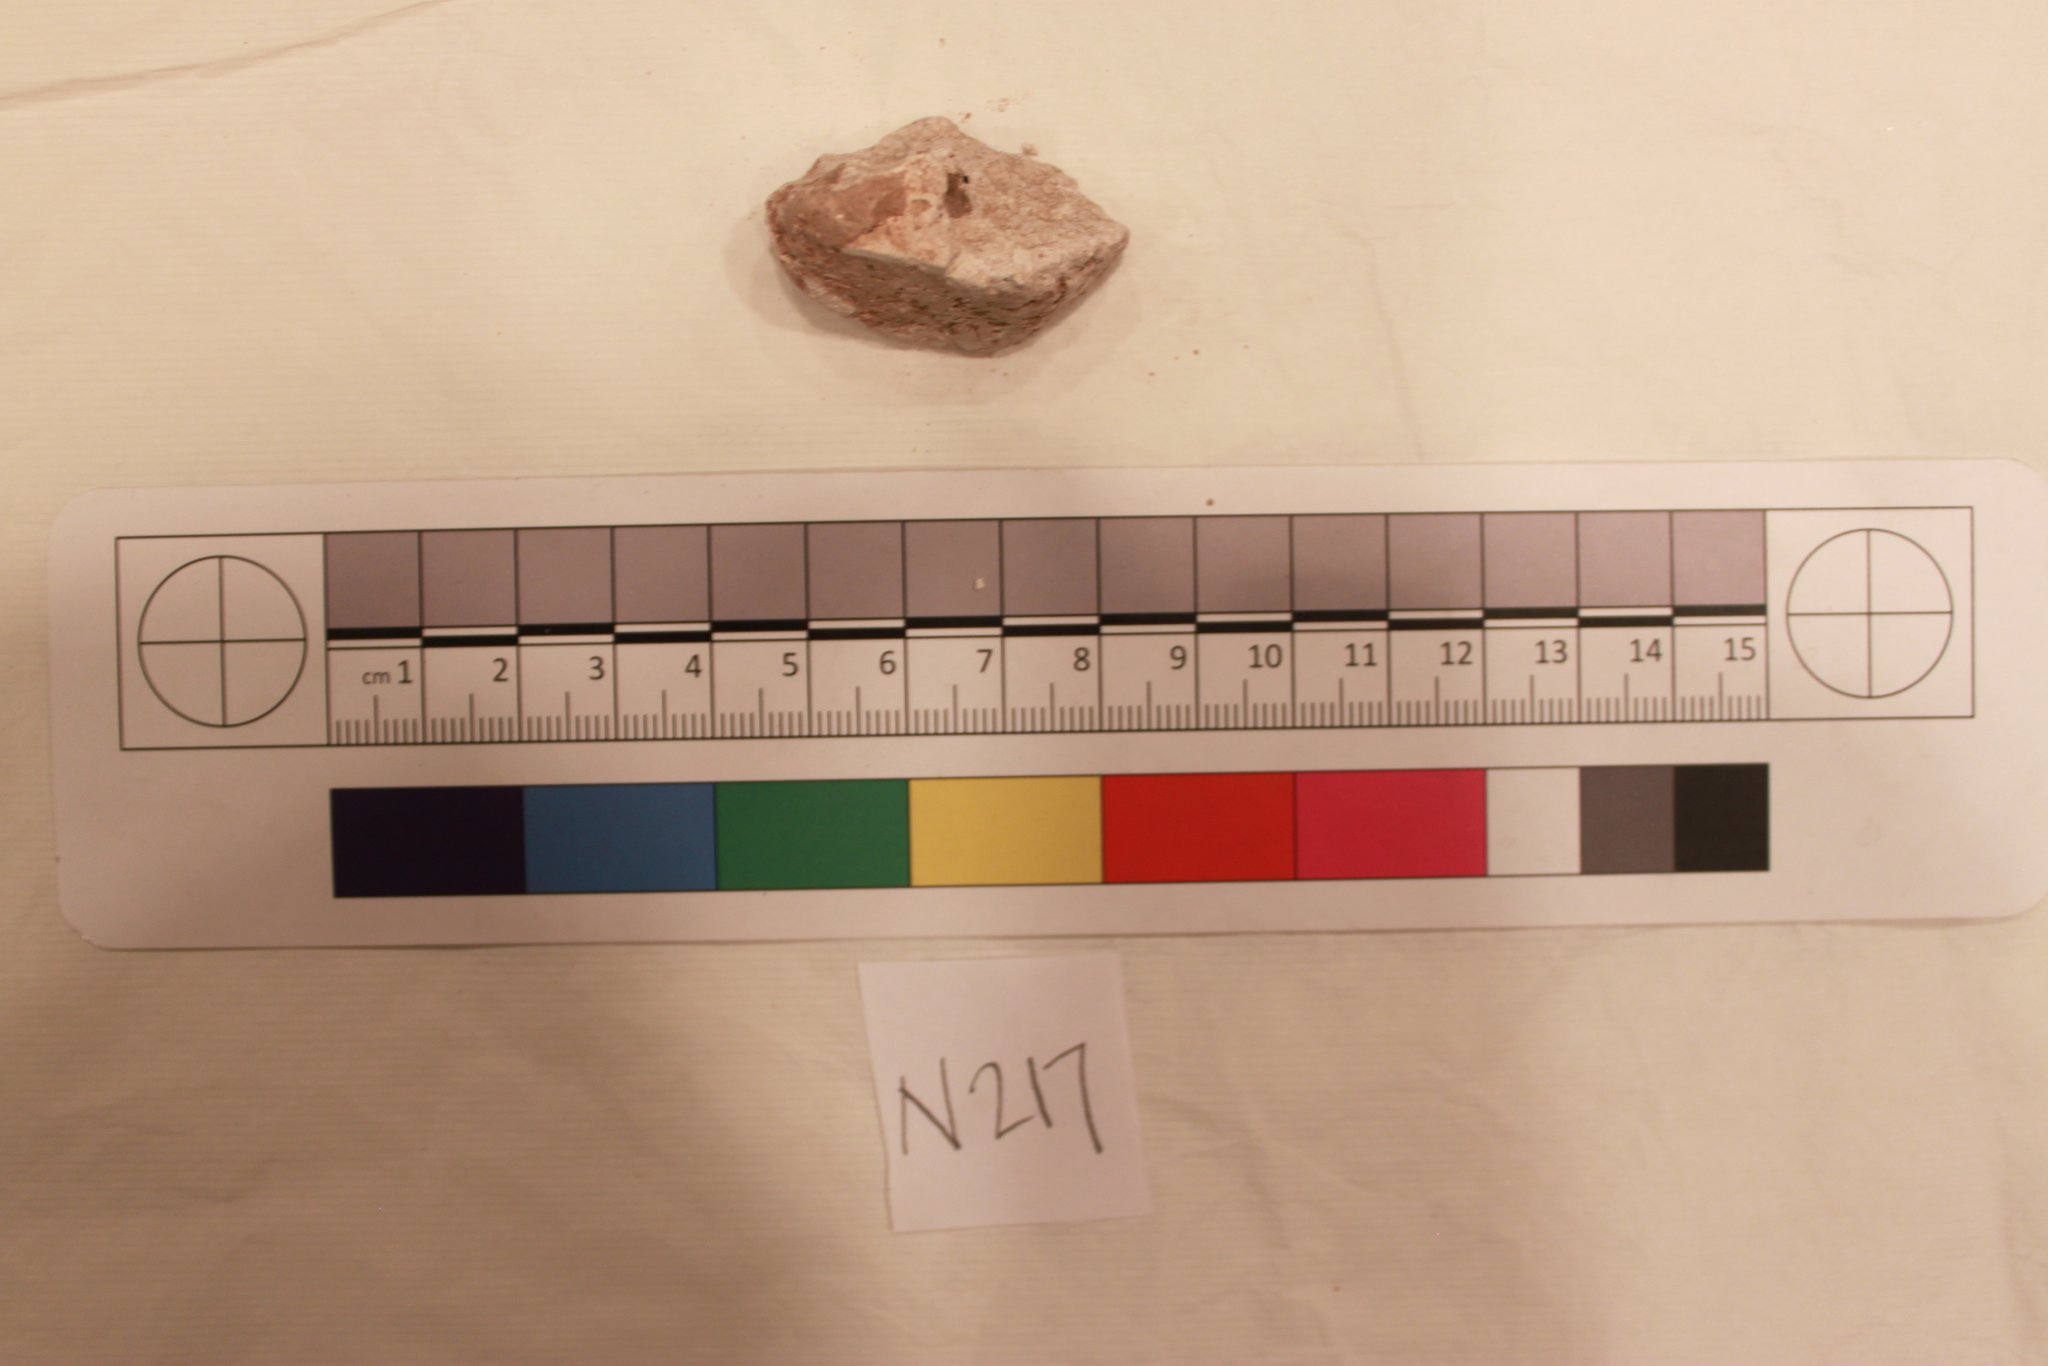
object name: fragment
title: Stucco Fragment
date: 701-1200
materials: plaster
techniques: carving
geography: iran